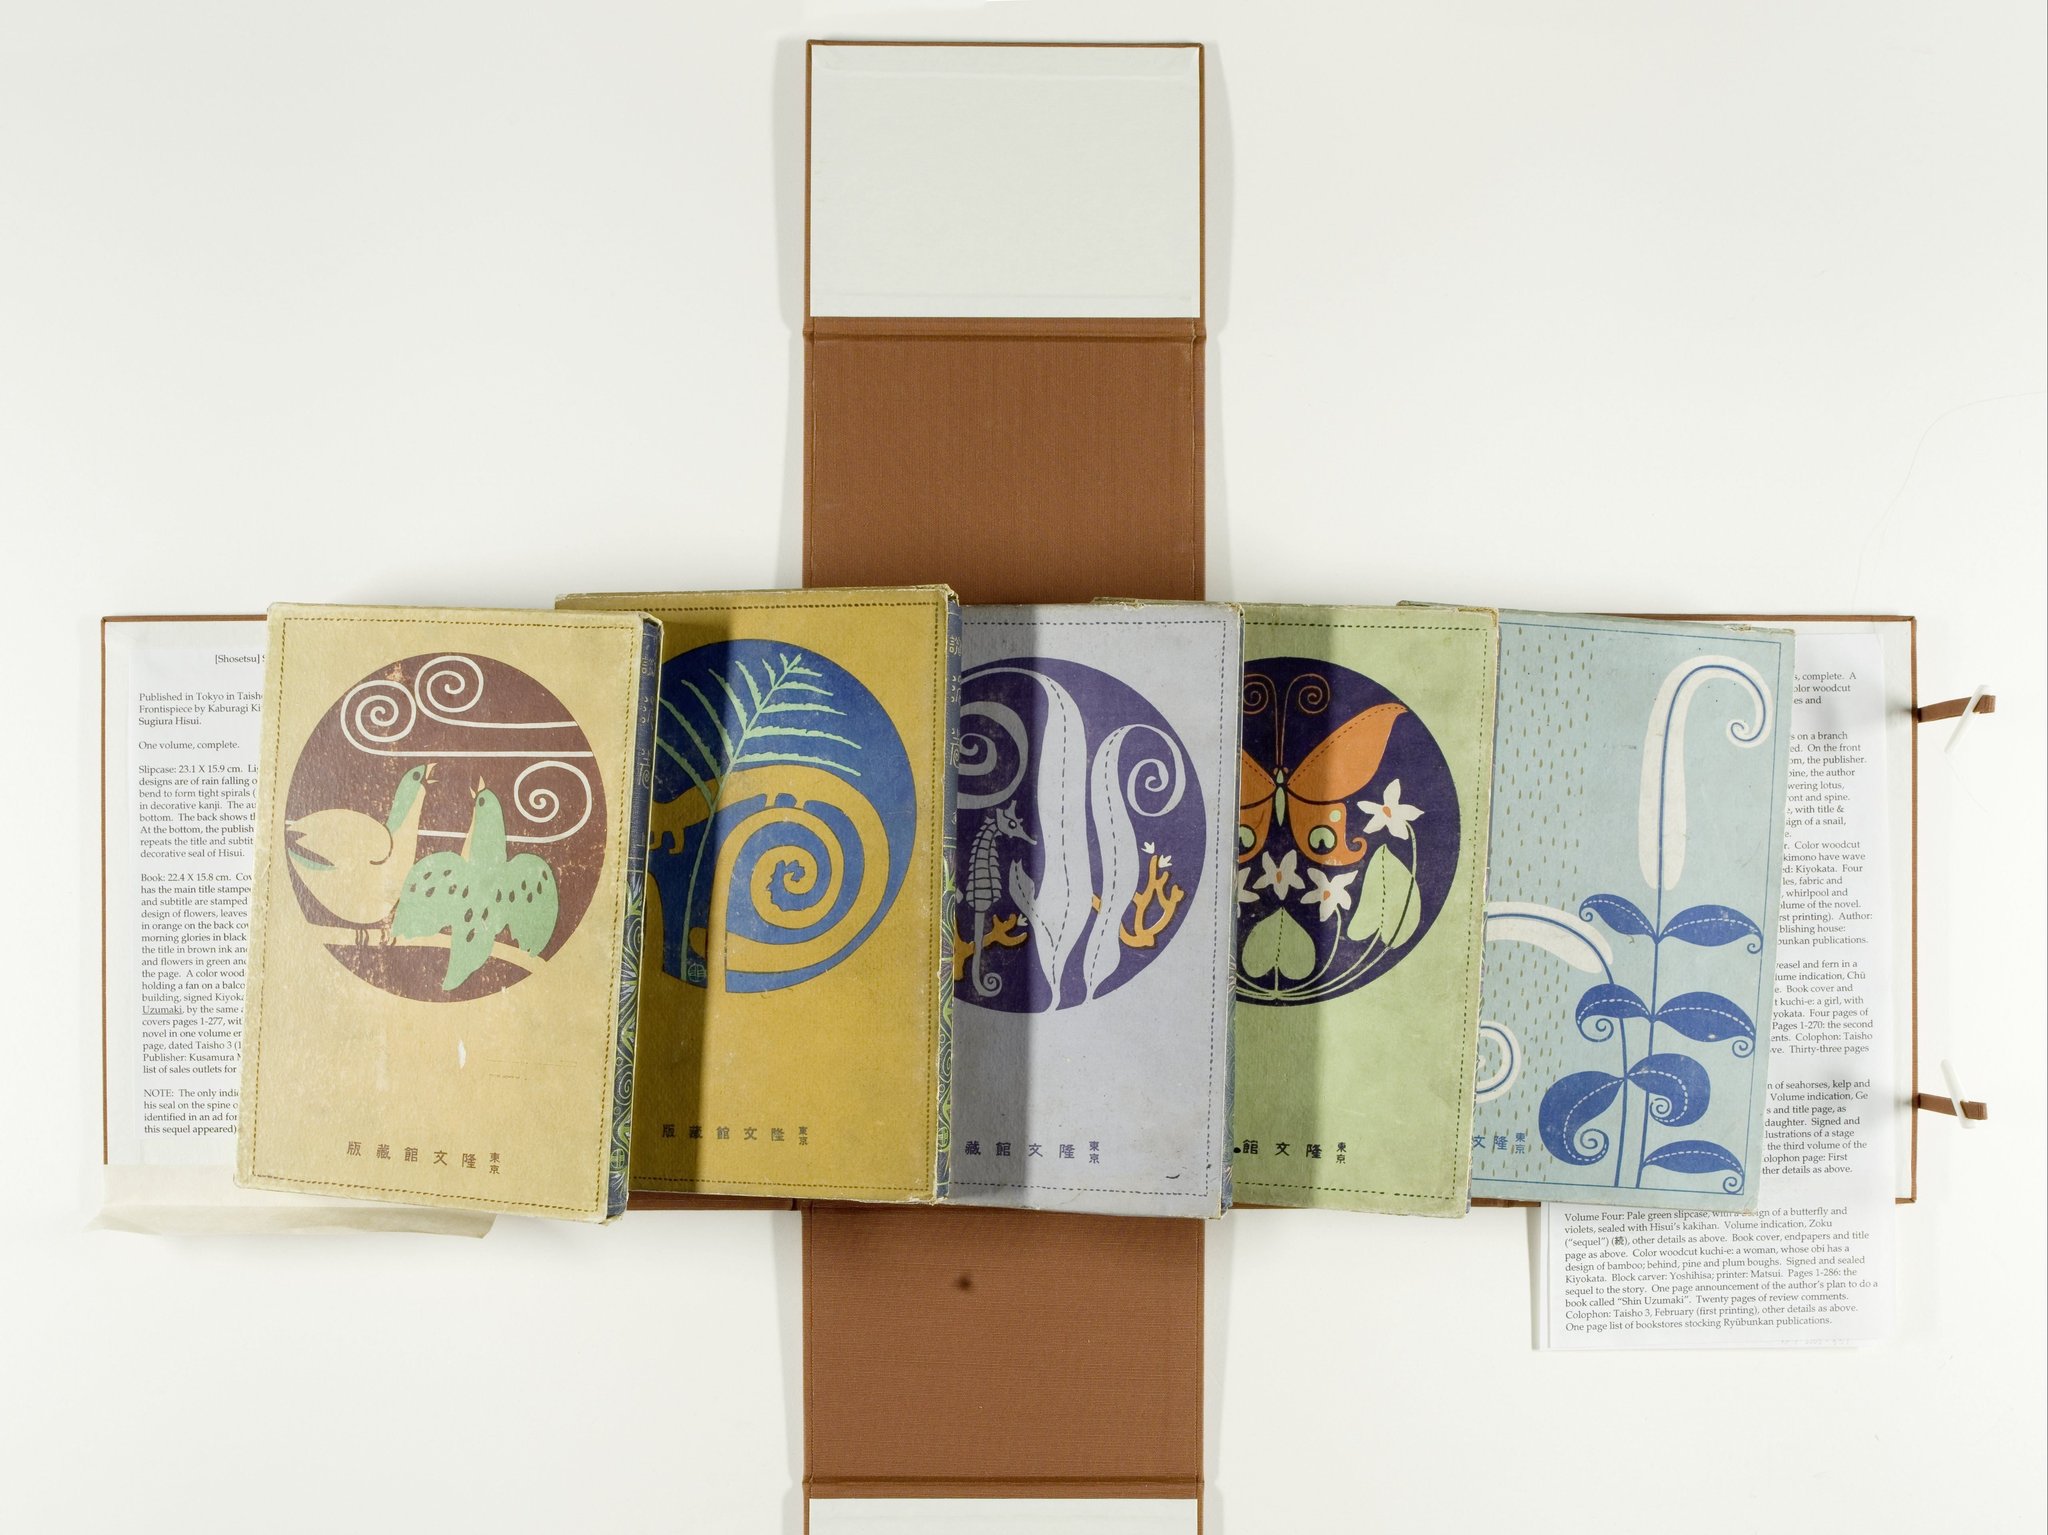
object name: book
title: Draaikolken - een roman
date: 1913-1914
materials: paper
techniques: woodcut, letterpress printing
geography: japan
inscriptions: date